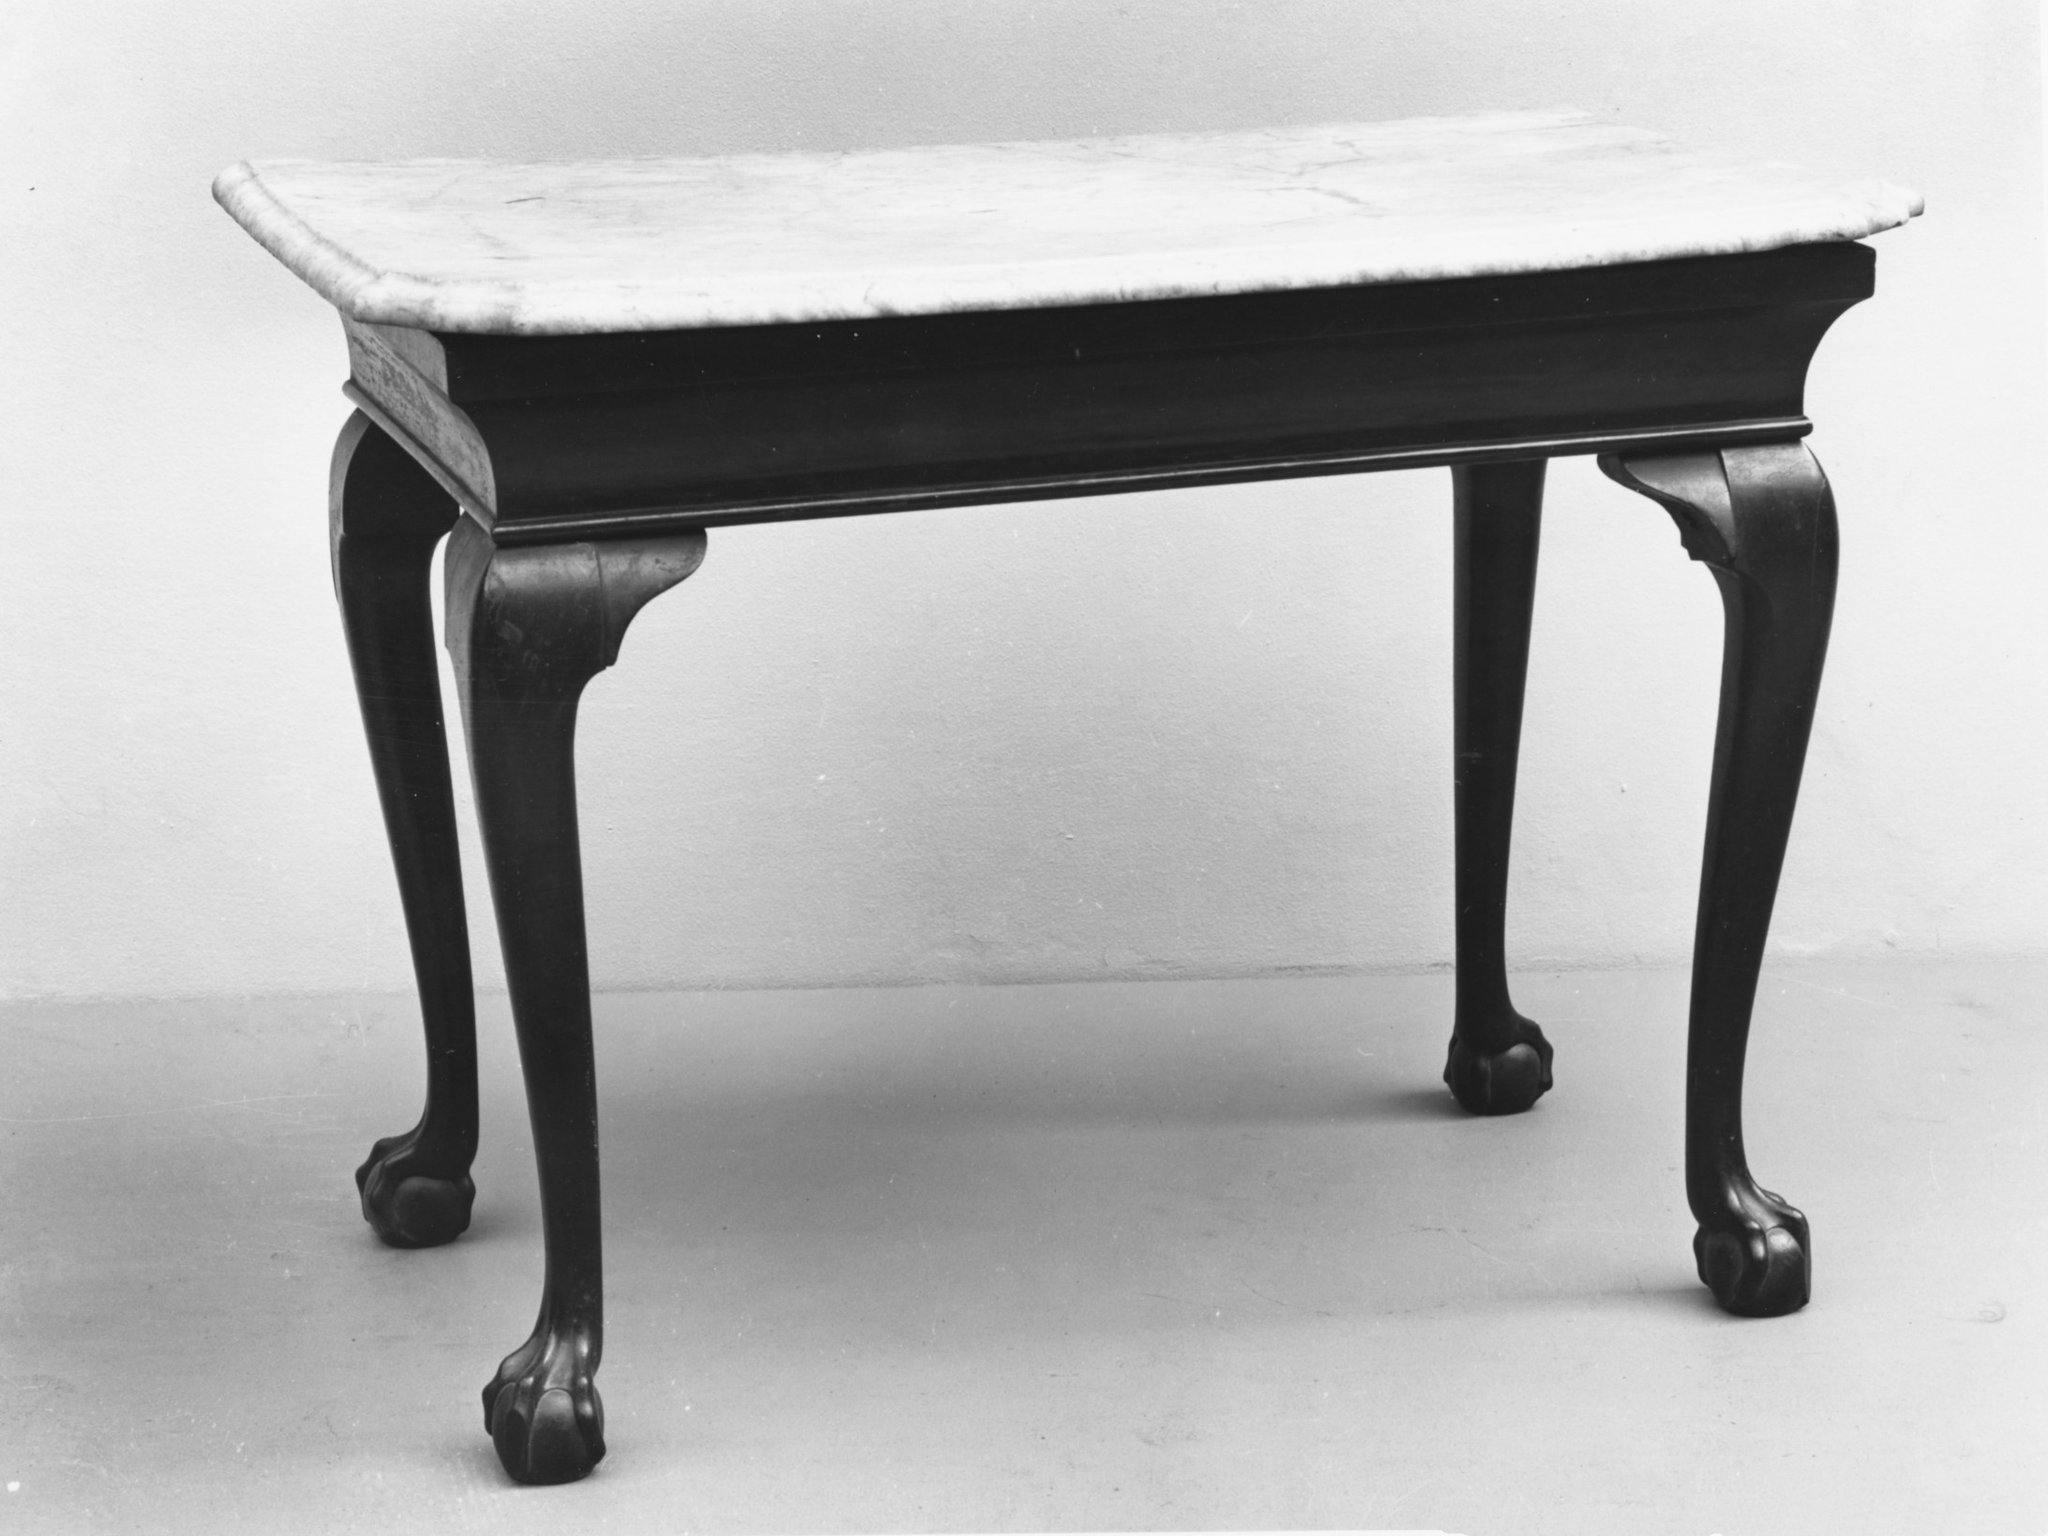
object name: table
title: Marble-slab table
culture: american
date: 1750-1770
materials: wood, marble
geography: united states